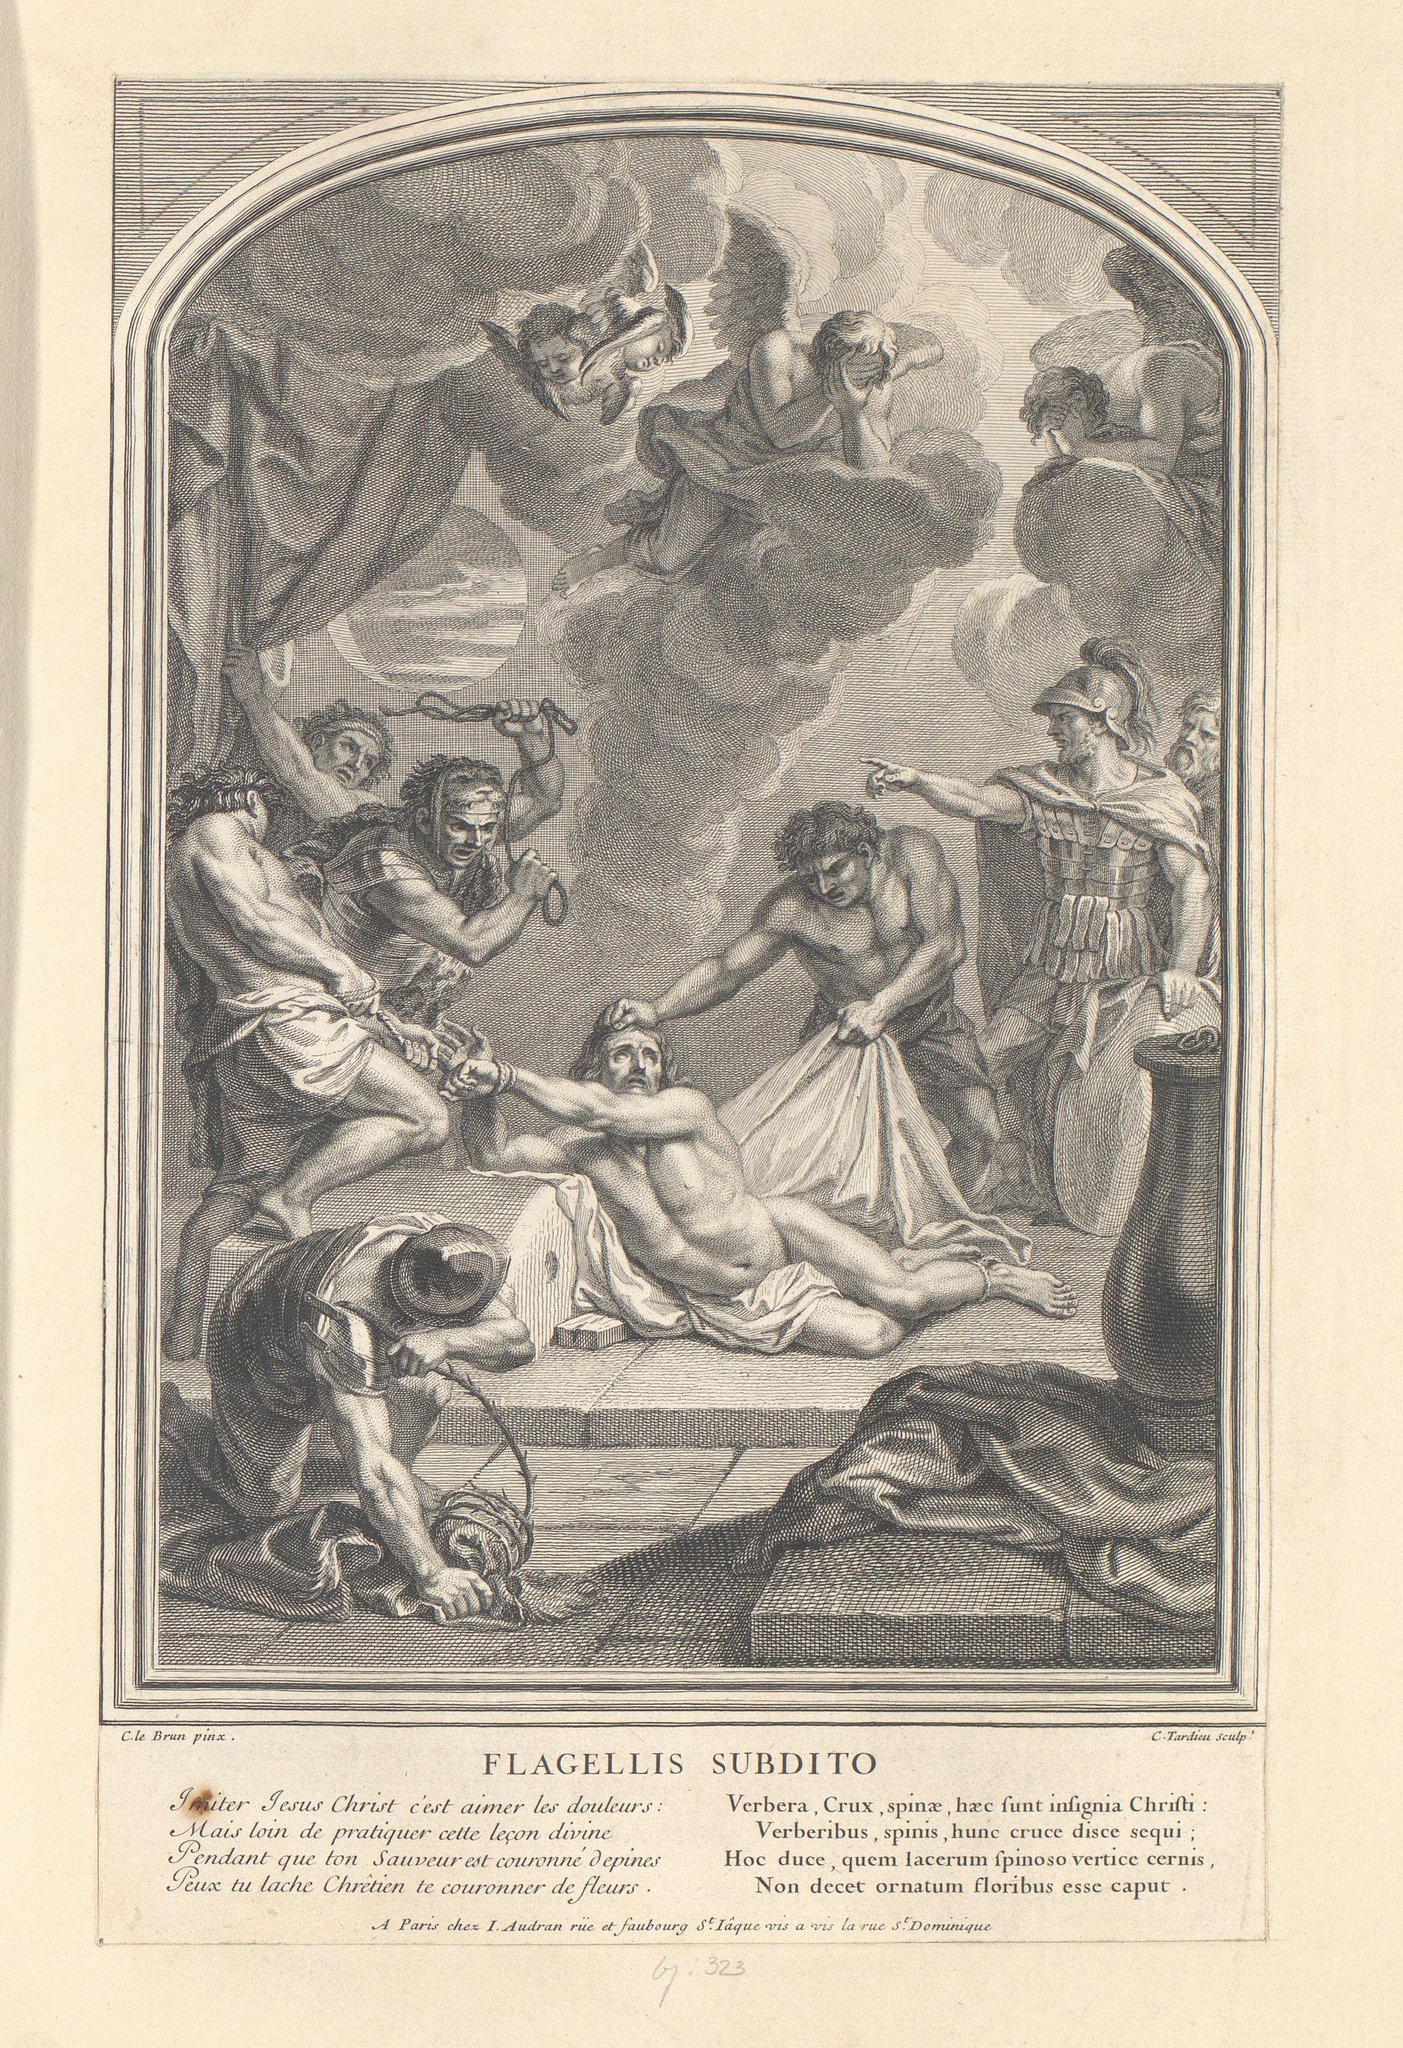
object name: album leaf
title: L'ouvrage de Charles le Brun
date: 1684-1749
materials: paper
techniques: engraving, etching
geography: paris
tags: flagellation by soldiers, christ usually tied to a column (matthew 27:26; mark 15:15; john 19:1)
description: Deze prent maakt deel uit van een album.